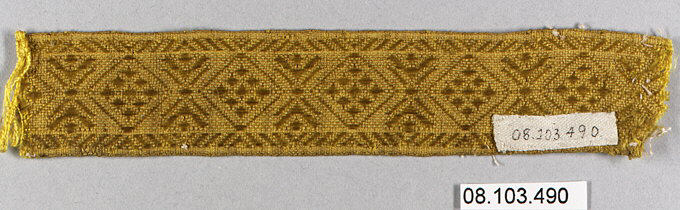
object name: galloon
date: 1701-1800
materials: cotton, silk